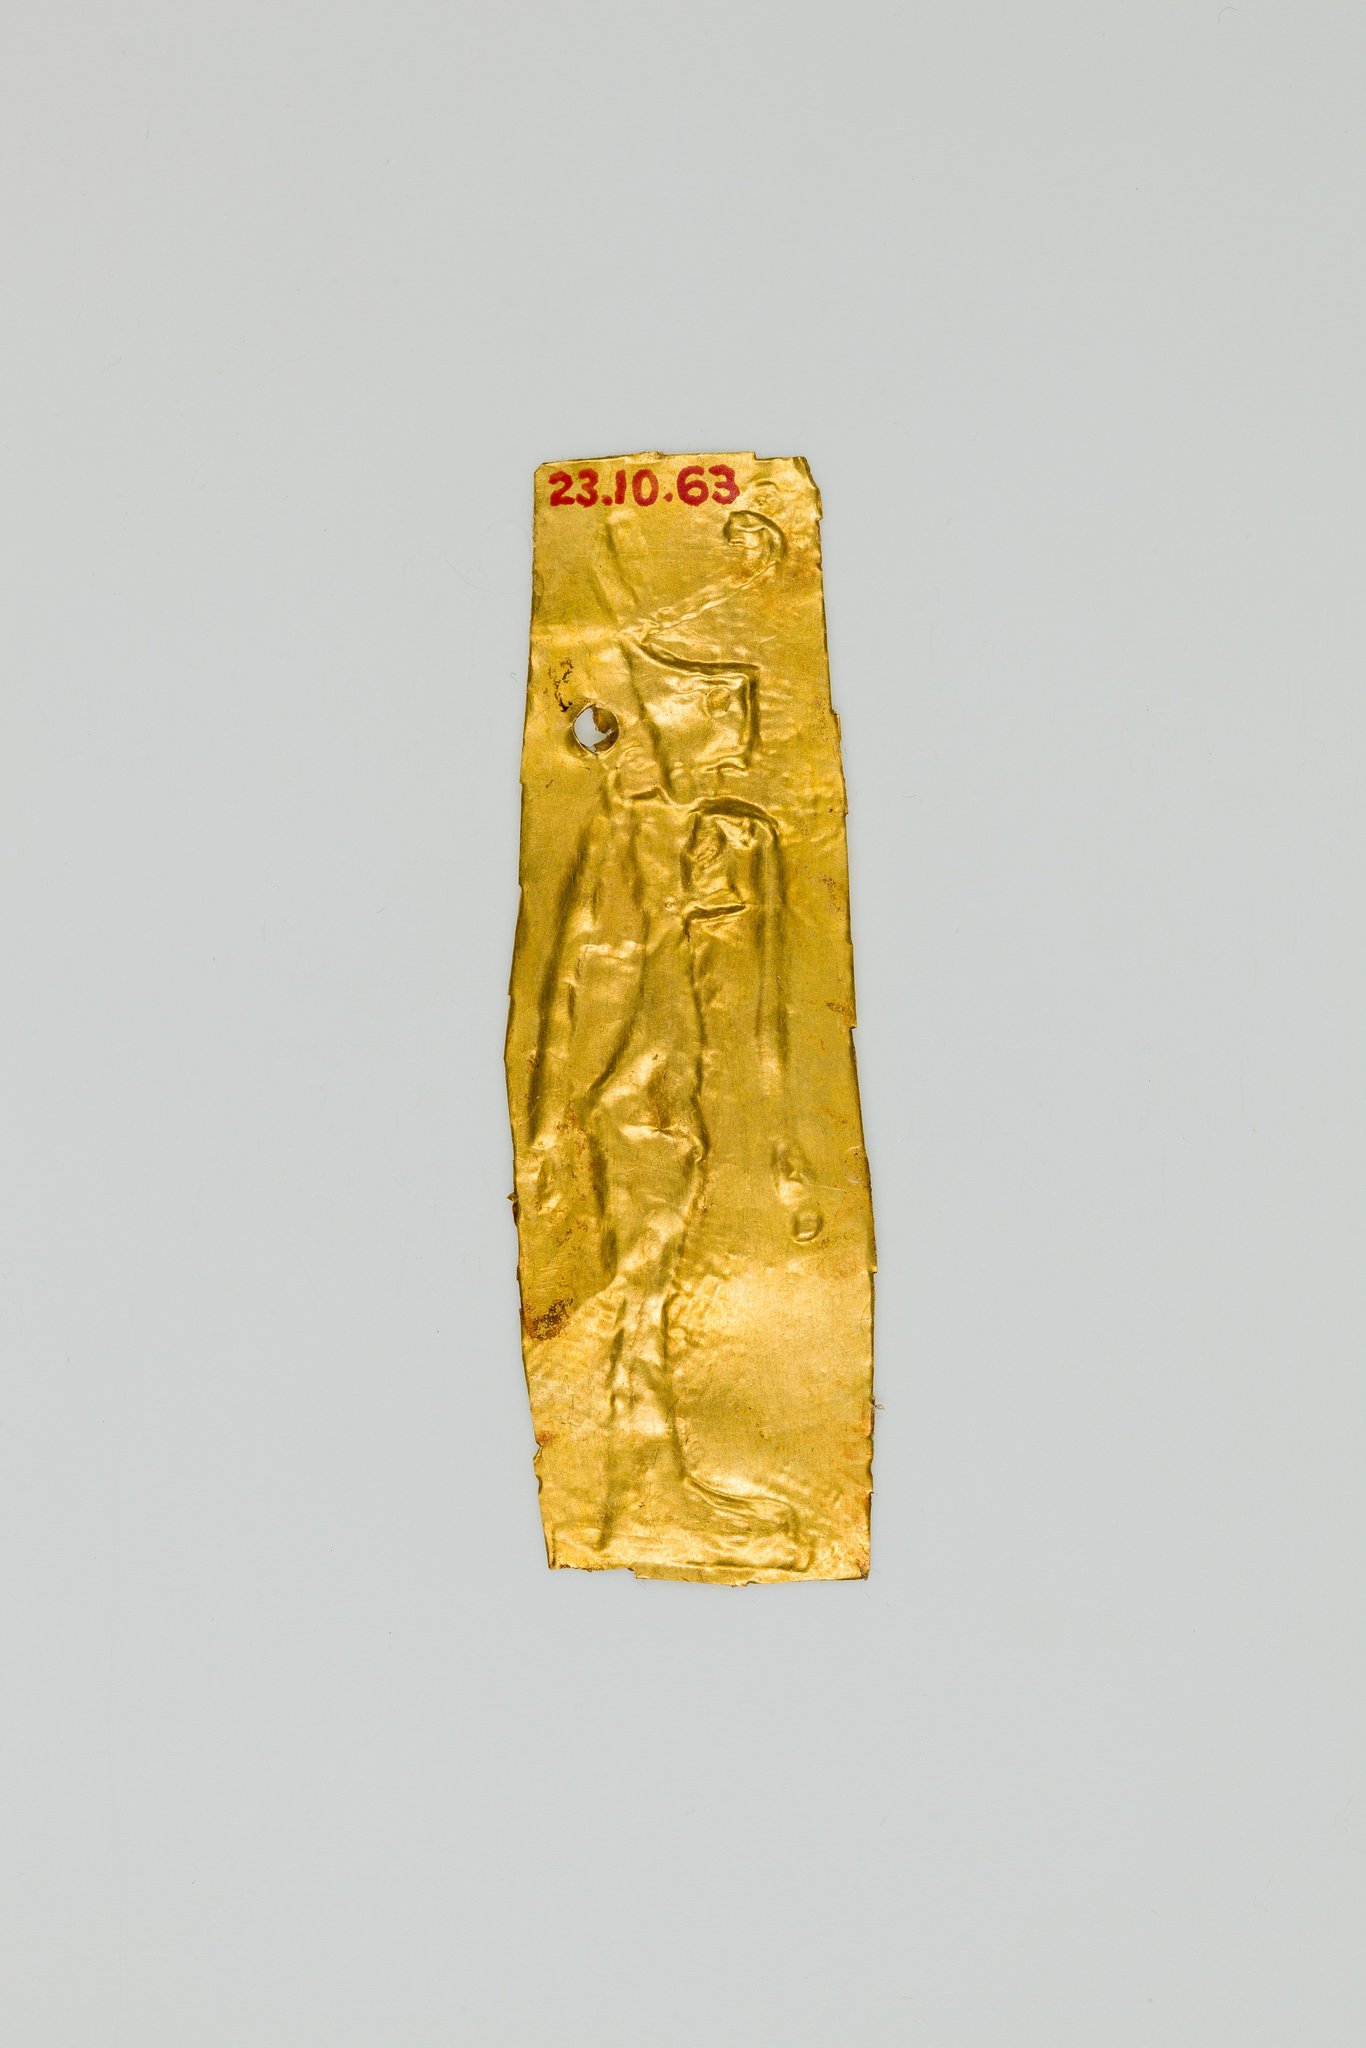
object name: amulet, neit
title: Neit (?) amulet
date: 664-380 BCE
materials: gold